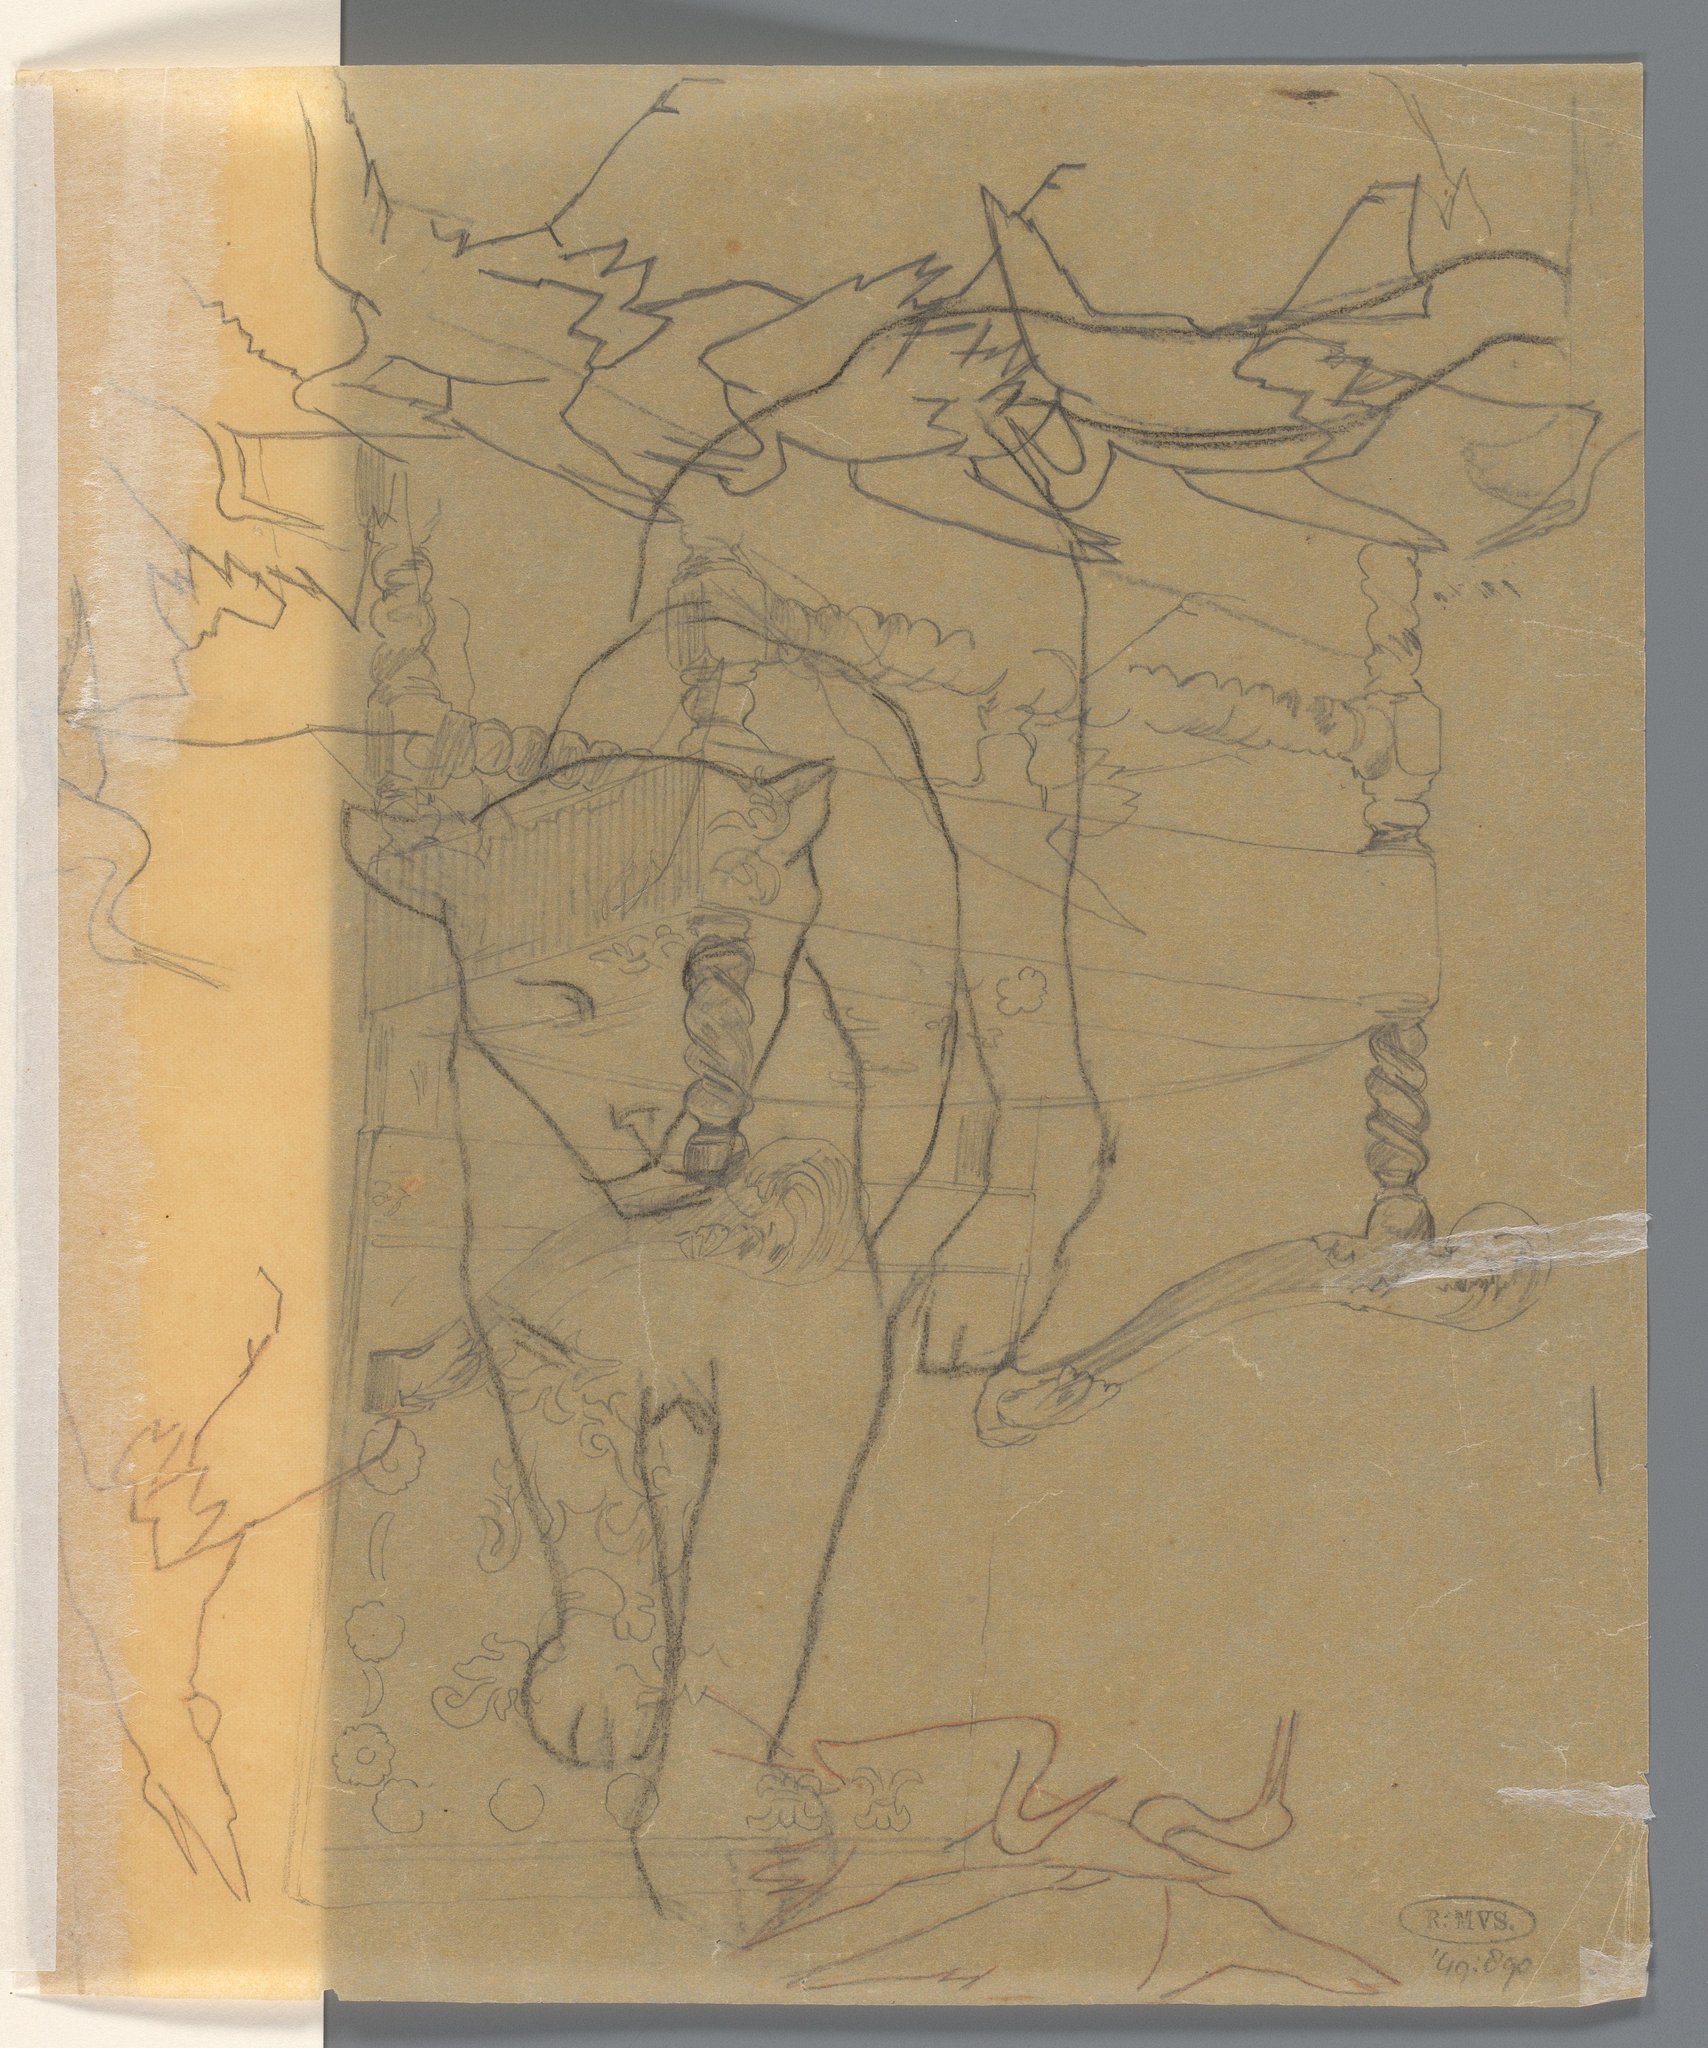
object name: drawing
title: Schetsblad met een stoel en een aantal flamingo's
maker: august allebé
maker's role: draughtsman, print maker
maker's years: 1838-1927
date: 1848-1927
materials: pencil, paper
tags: shore-birds and wading-birds: flamingo, chair